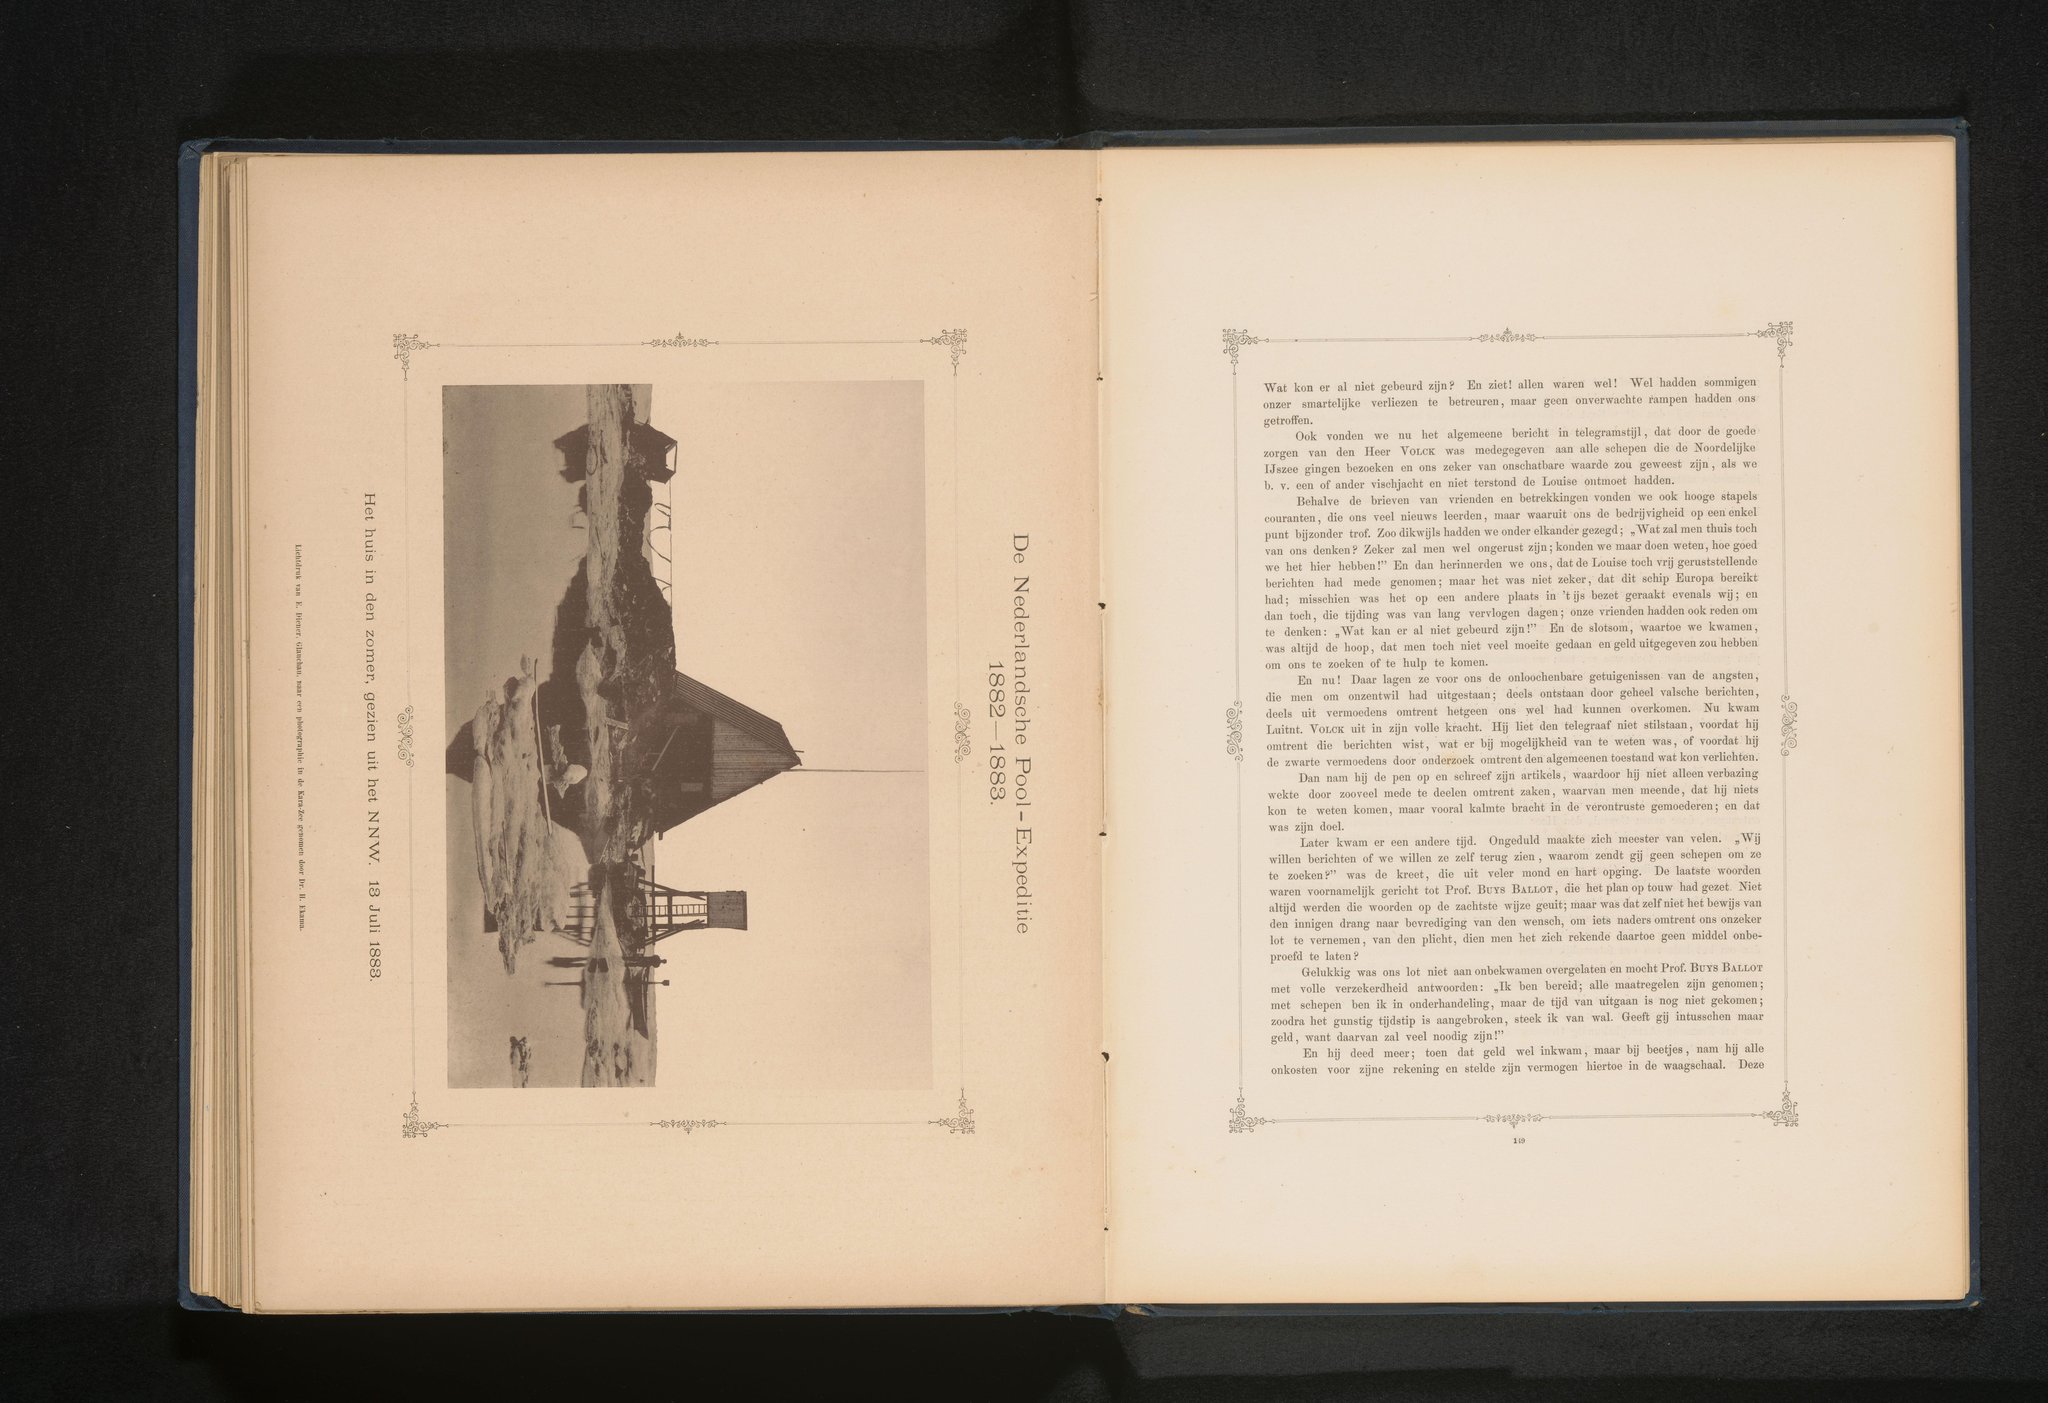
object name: photomechanical print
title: Gezicht op een huis in de Karazee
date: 1881-1886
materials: paper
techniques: photograph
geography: glauchau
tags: iceberg, landscapes in polar regions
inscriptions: inscription: ‘De Nederlandsche Pool-Expeditie 1882-1883’